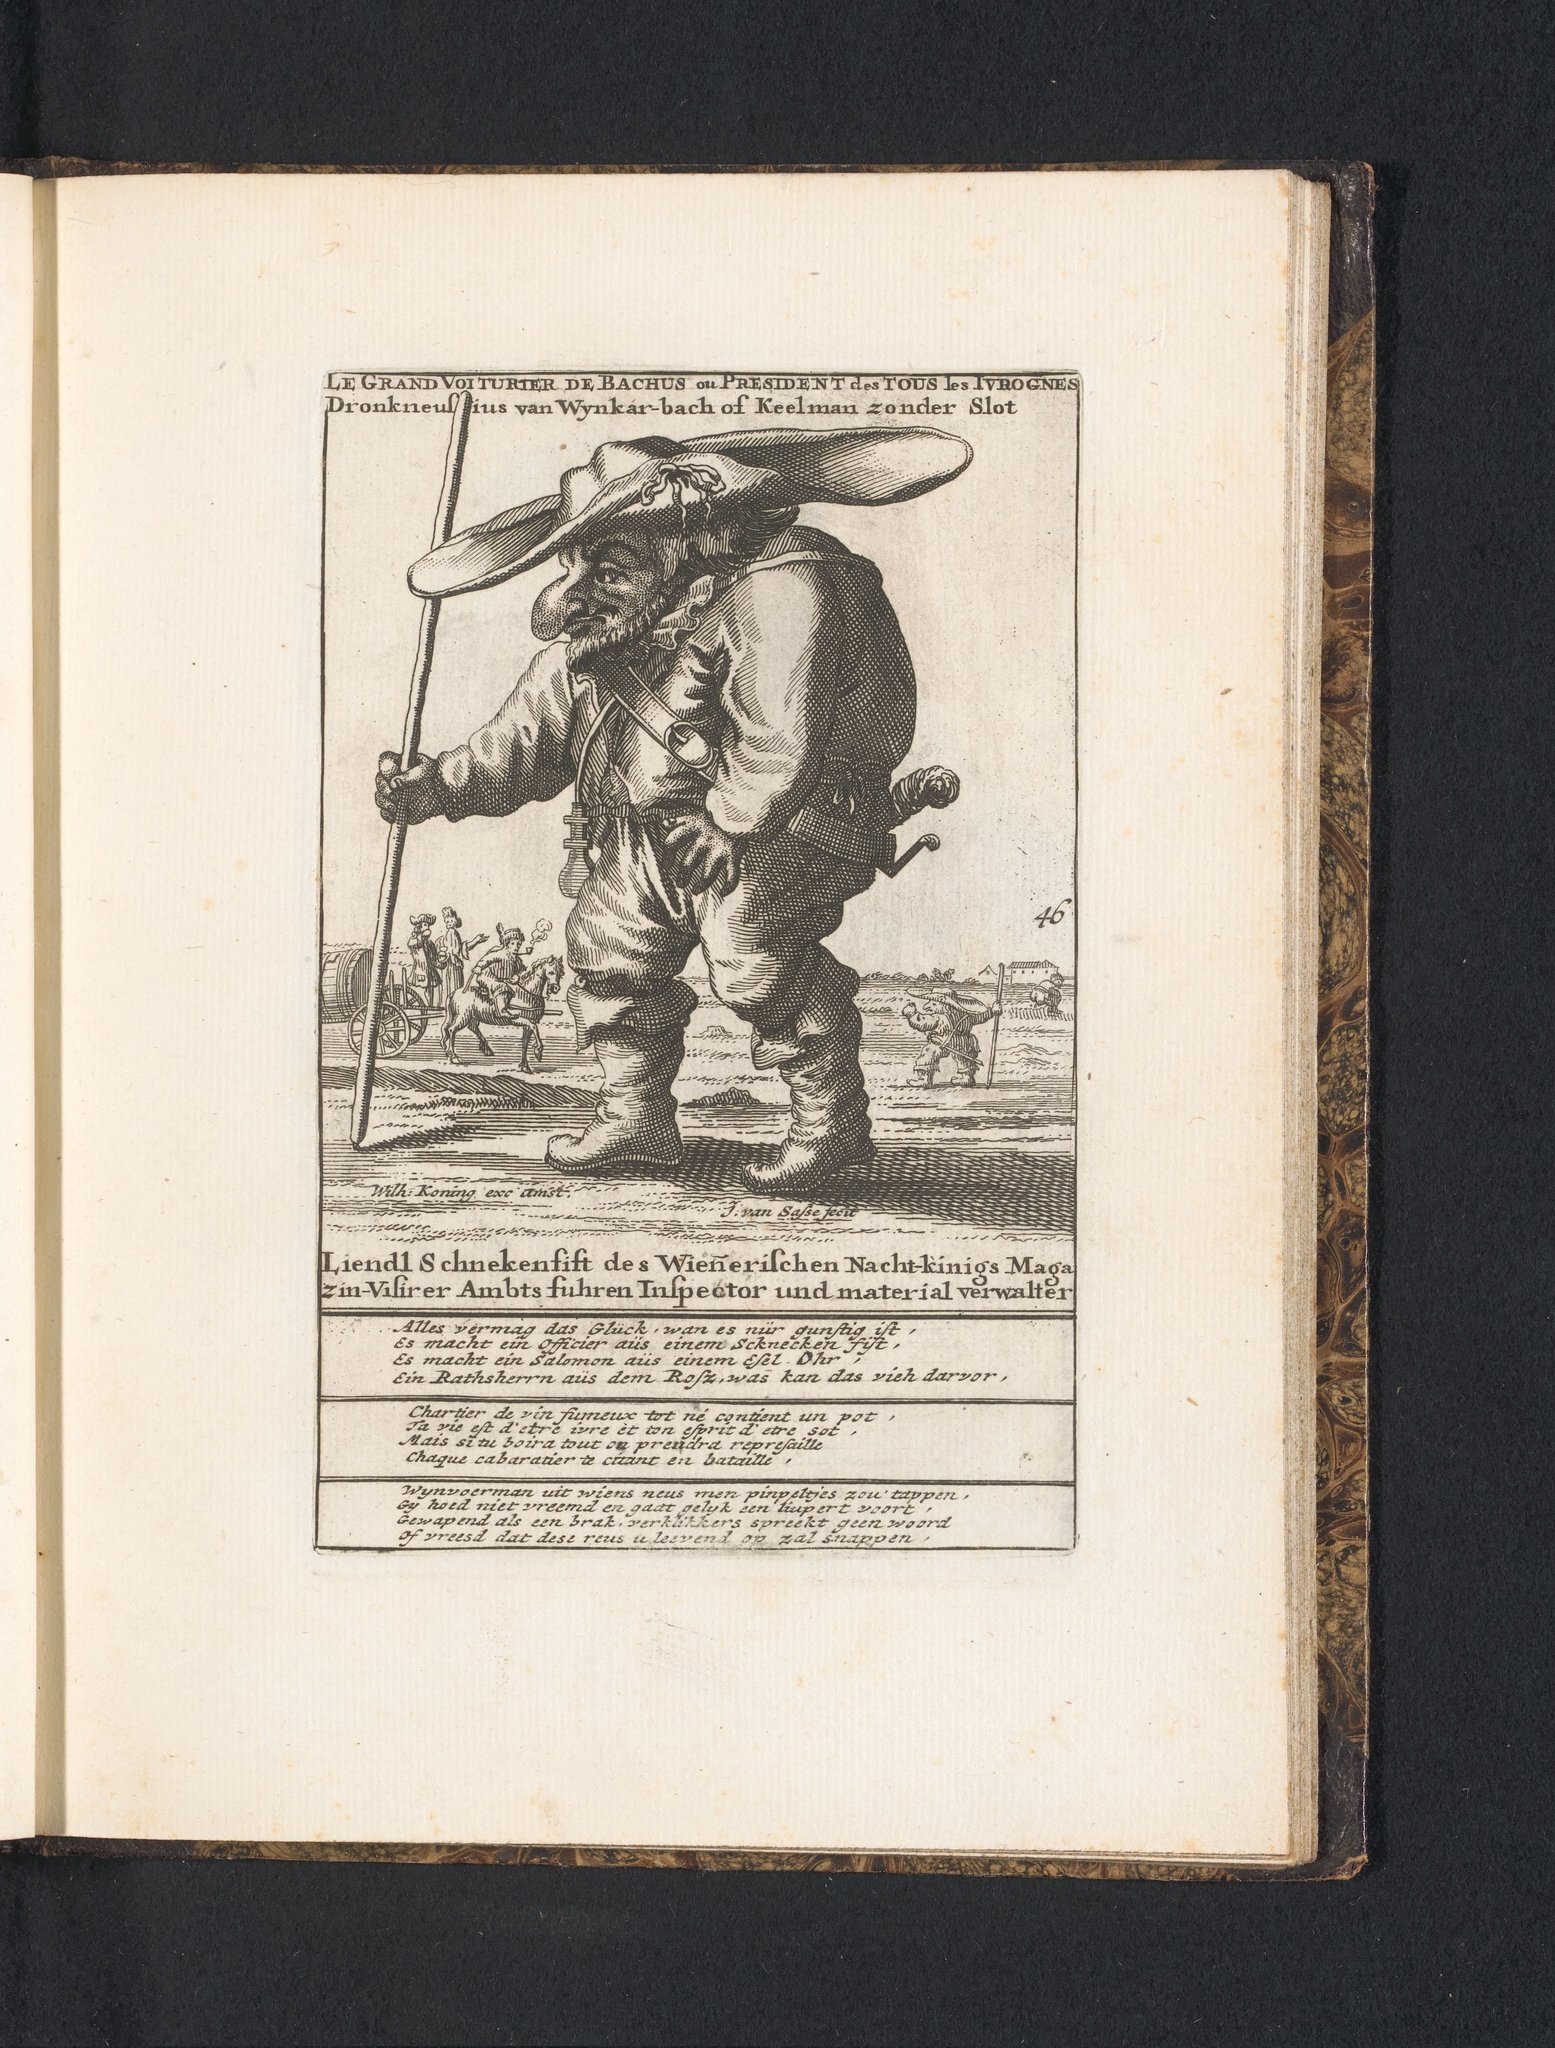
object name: print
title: Le Grand Voiturier de Bachus ou President des Tous les Ivrognes / Dronkneussius van Wynkar-bach of Keelman zonder Slot / Liendl Schnekenfist des Wienerischen Nacht-kinigs Magazin-Visirer Ambts fuhren Inspector und material verwalter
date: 1718-1720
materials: paper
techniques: etching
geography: northern netherlands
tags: caricatures (human types), little people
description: De kleine mens Dronkneussius van Wynkar-bach als inspecteur te Wenen. In het onderschrift verzen in het Duits, Frans en Nederlands. Genummerd rechts midden: 46. Onderdeel van deel II in de tweede Nederlandse gebonden uitgave uit 1720 (en gerelateerd aan de Windhandel in dat jaar) van een serie karikaturen van kleine mensen, bekend als Het Dwergentooneel.